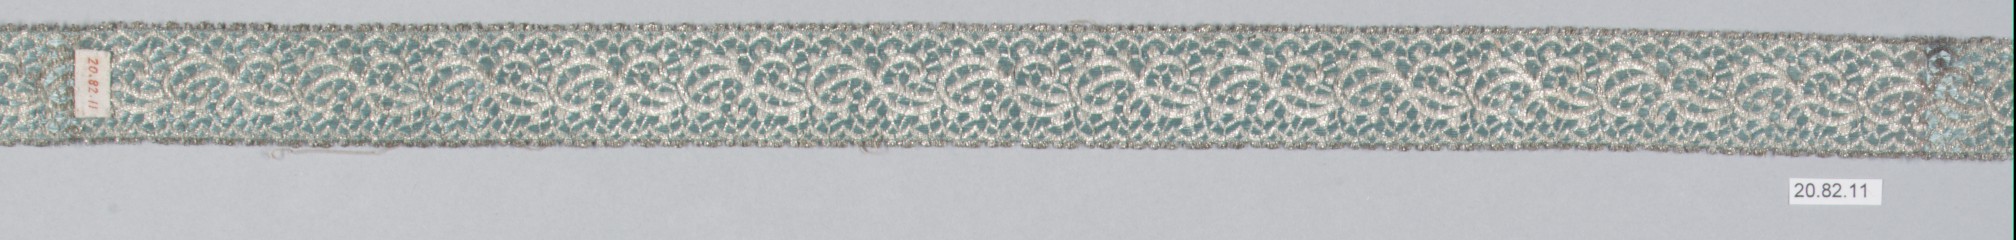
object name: ribbon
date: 1801-1833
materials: metal thread, silk